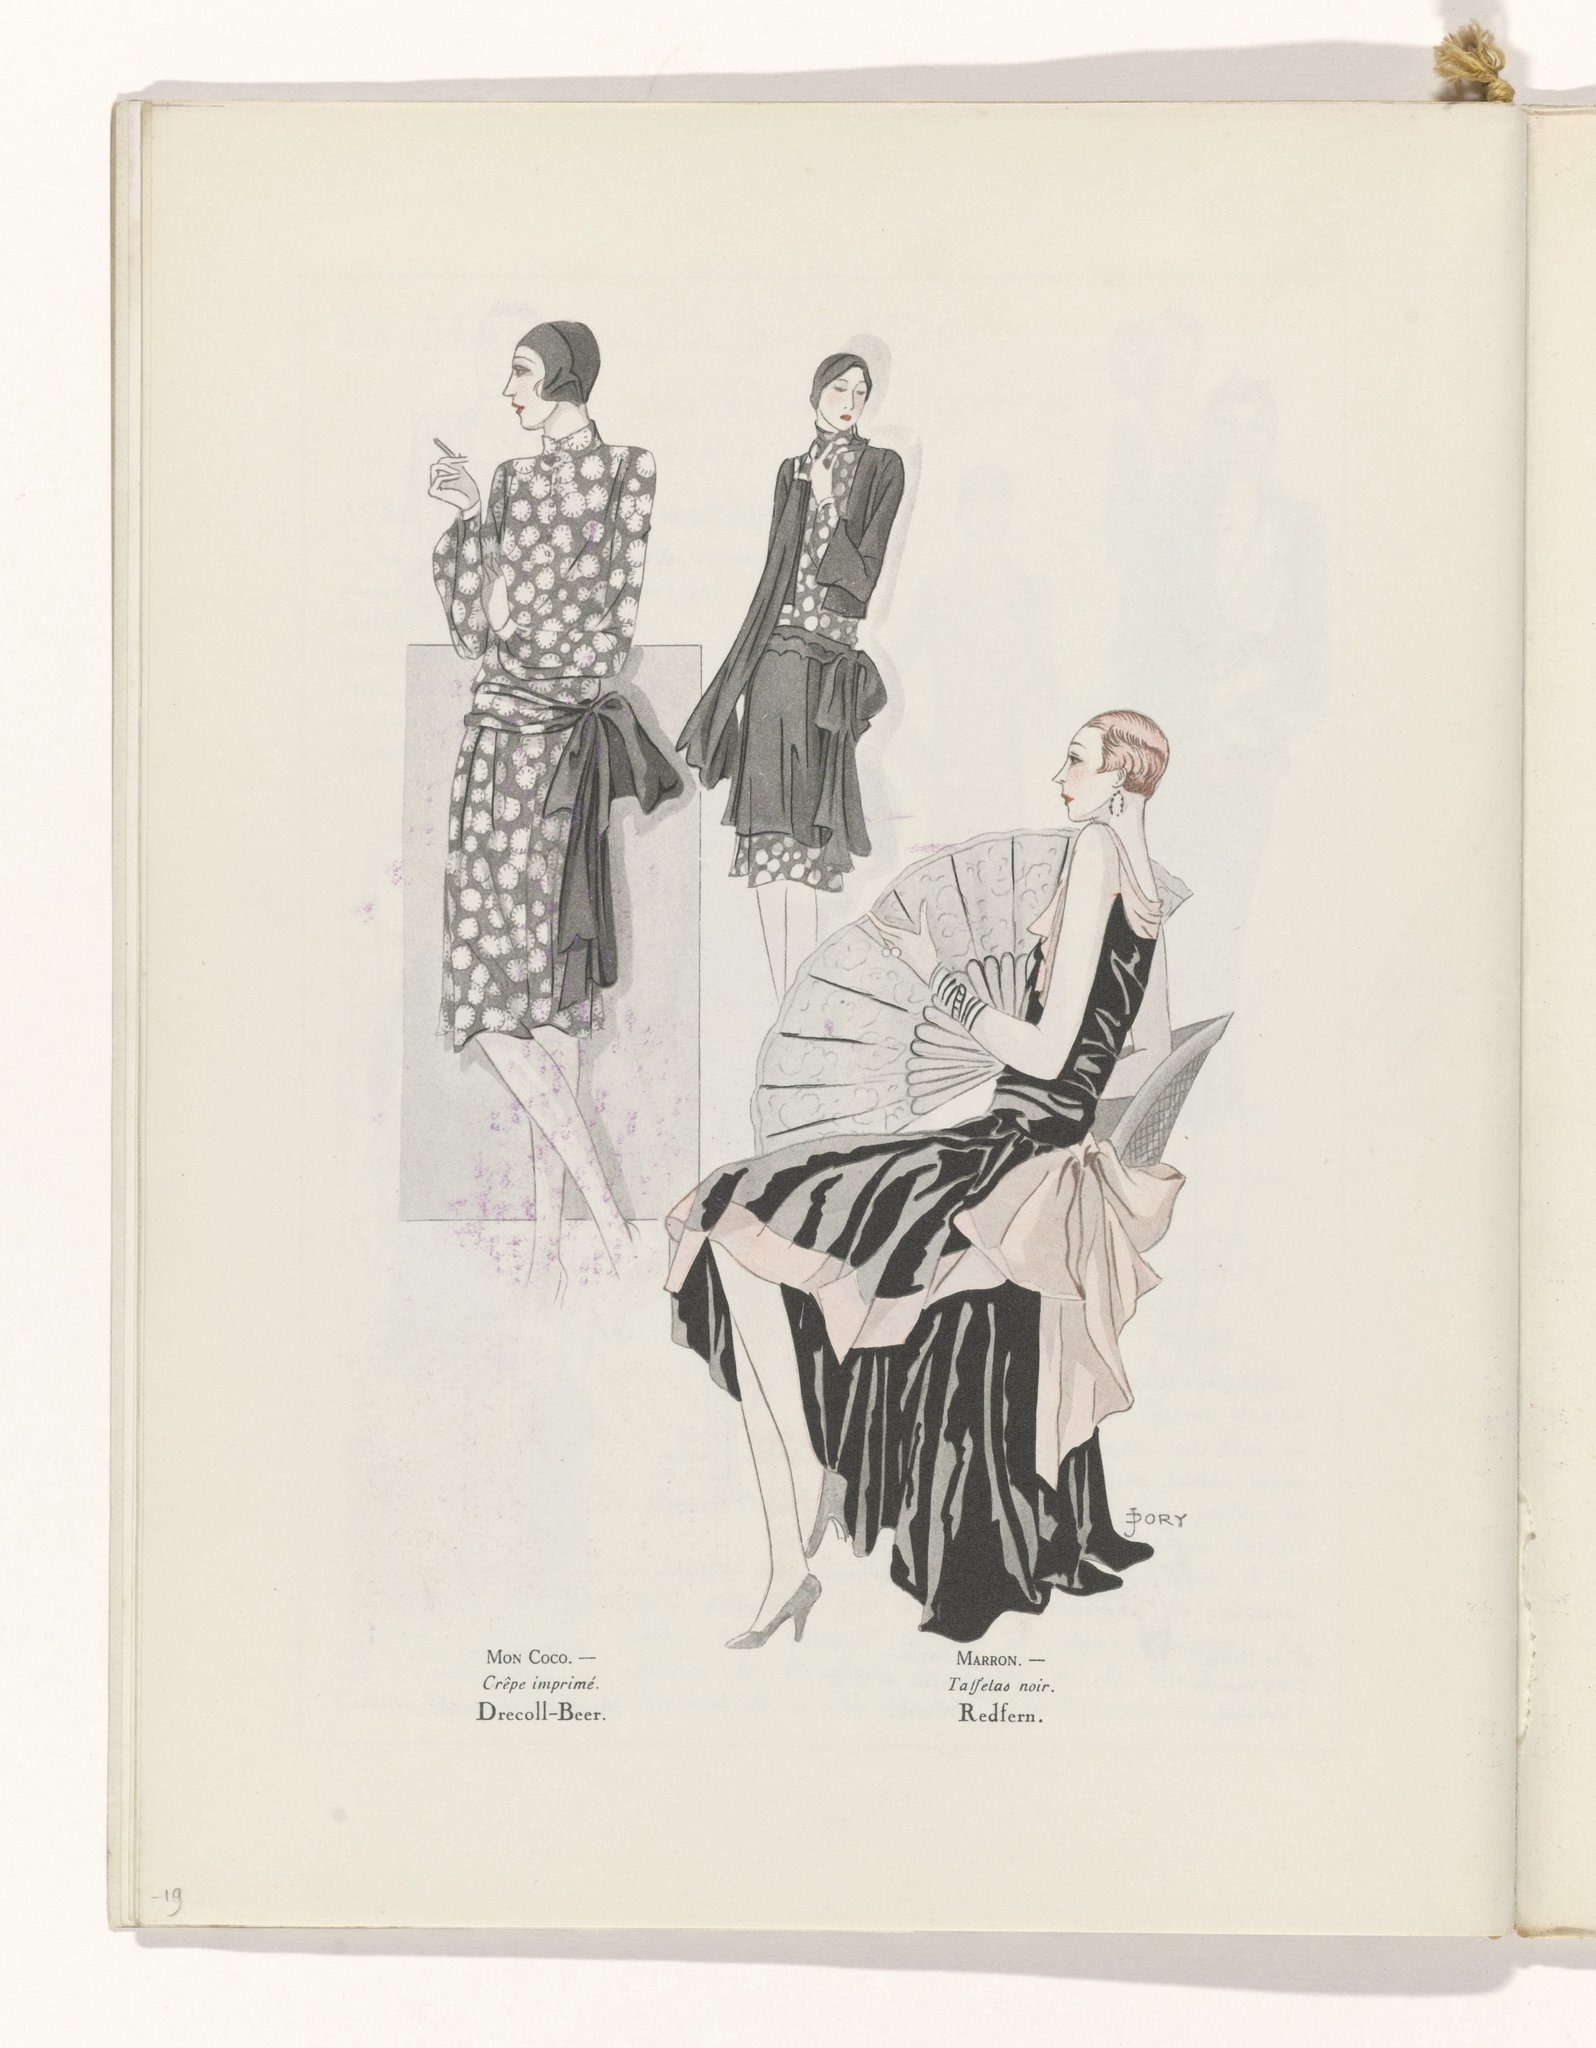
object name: magazine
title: Art - Goût - Beauté, Feuillets de l' élégance féminine, Juin 1929, No. 106, 9e Année, p.19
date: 1929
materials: paper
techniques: printing, photography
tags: bow (ornamental part of clothing) (+ women's clothes), dress, gown: evening dress (+ women's clothes), cigarette, fashion plates, head-gear: hat (+ women's clothes), fan (+ women's clothes)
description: Twee vrouwen in japon van gedrukte crêpe, van Drecoll-Beer. Zittende vrouw met een grote waaier in de hand, gekleed in een avondjurk van zwarte tafzijde, van Redfern. Pagina uit het modetijdschrift Art-Goût-Beauté (1920-1933).